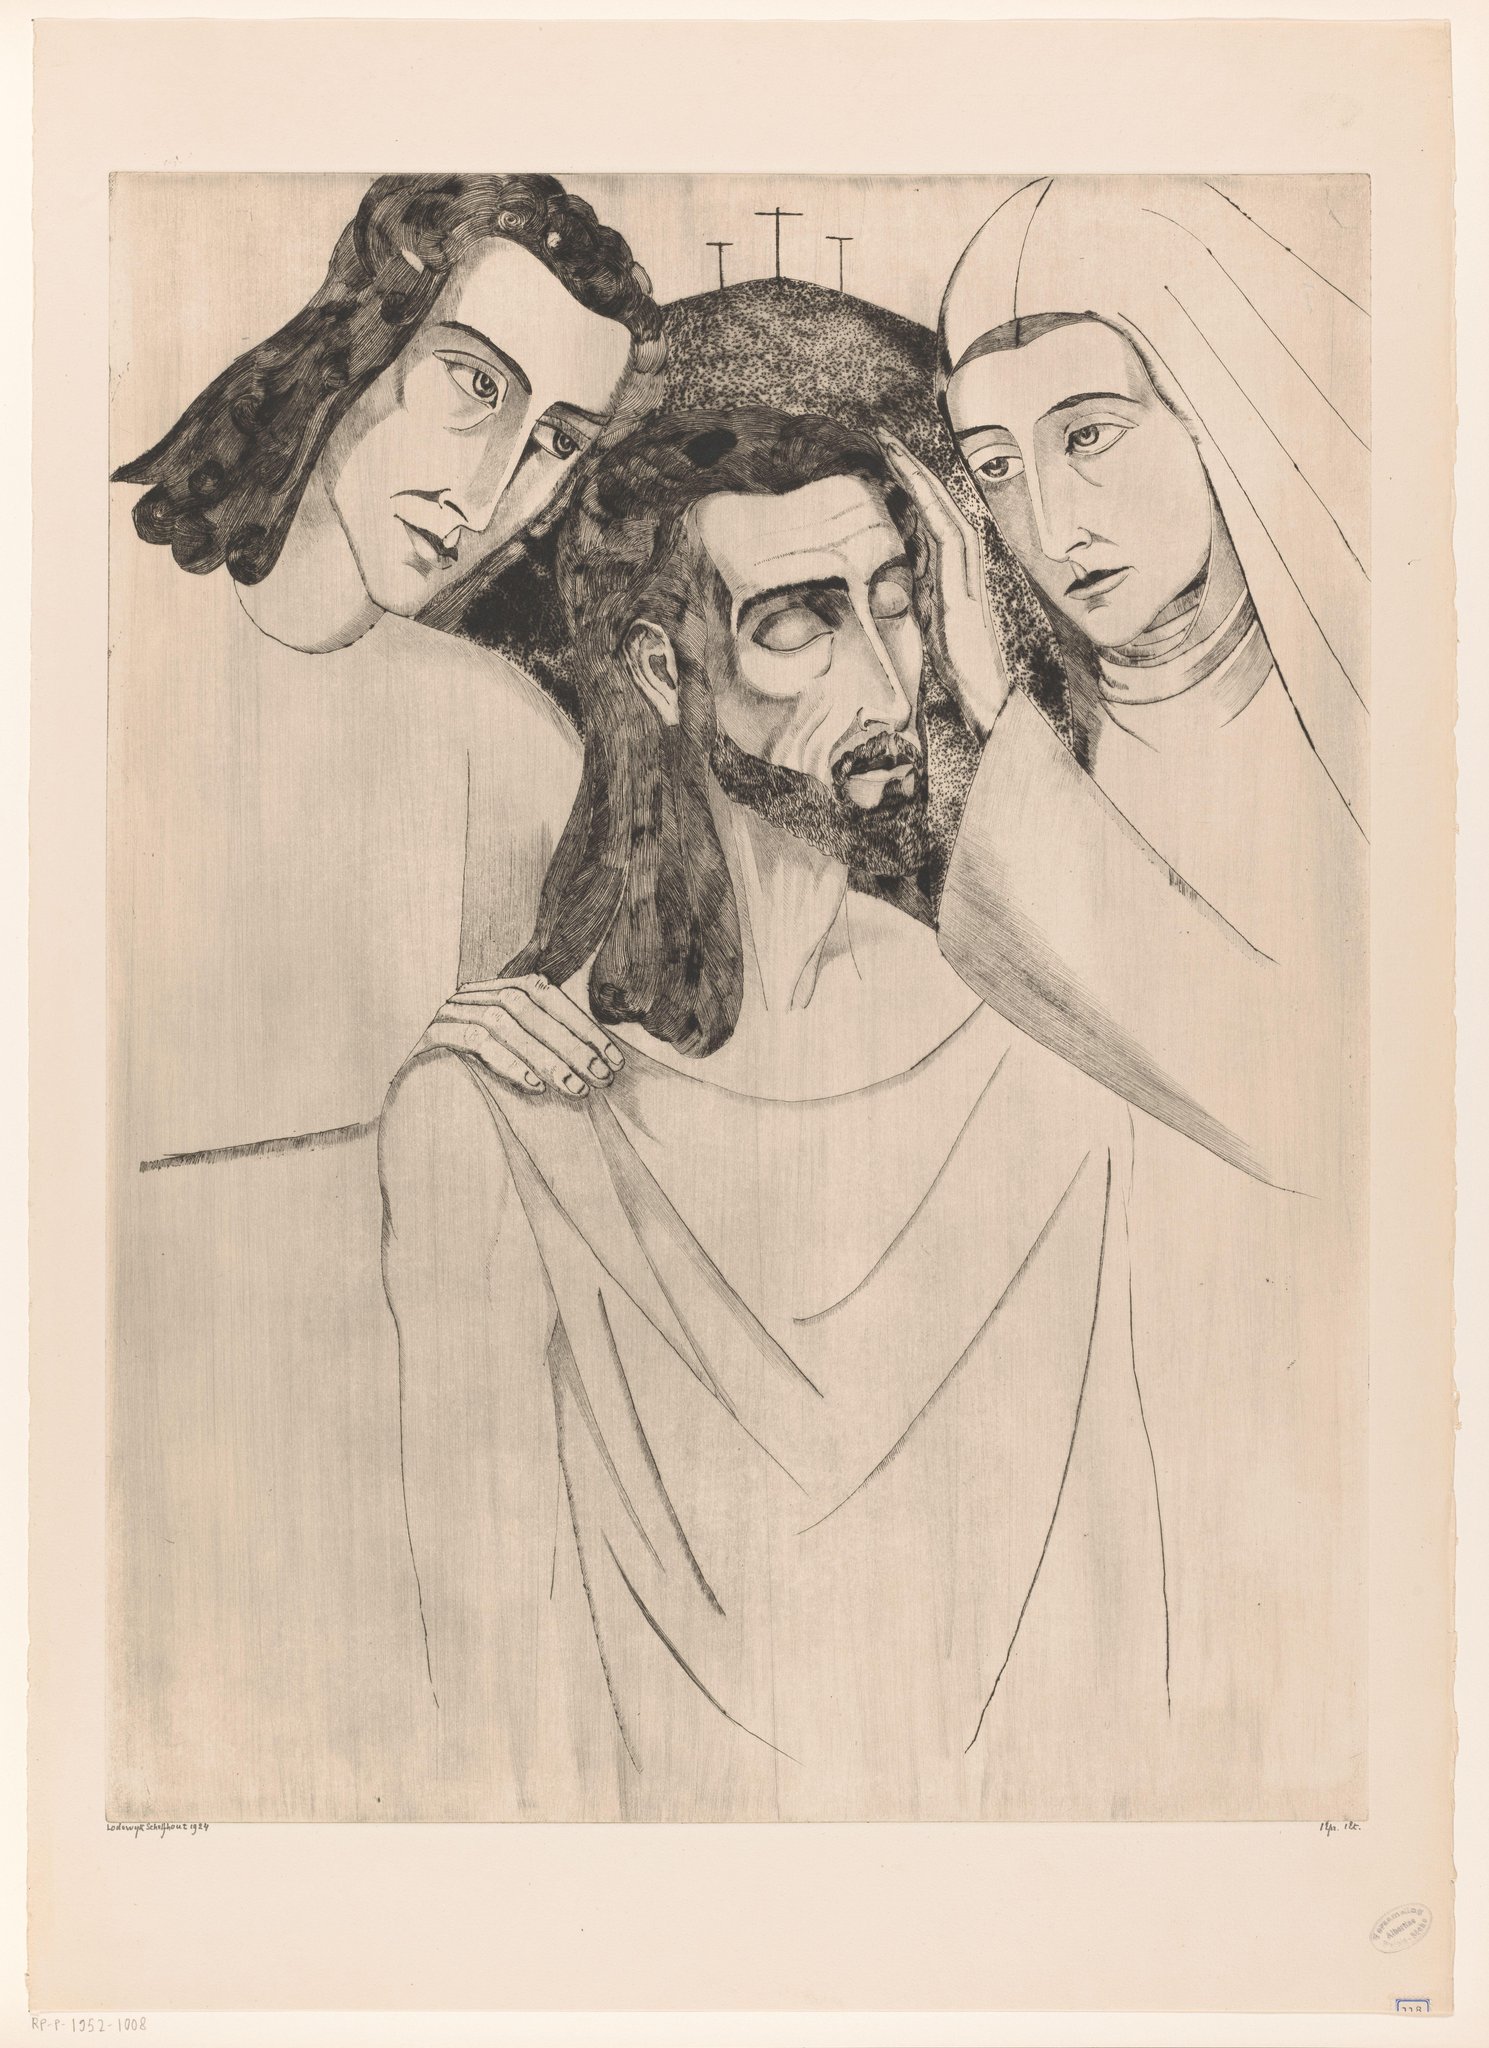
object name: print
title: Le Christ, sa mère et Saint Jean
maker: lodewijk schelfhout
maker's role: draughtsman, print maker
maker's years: 1881-1943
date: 1924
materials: paper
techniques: drypoint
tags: adult christ together with others (non-narrative representations), the virgin mary, series of scenes from the life of john the baptist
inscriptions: collector's mark: Lugt 2760, collector's mark: Lugt 5i, collector's mark: Lugt 2228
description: Op de achtergrond de heuvel Golgota met de drie kruisen.